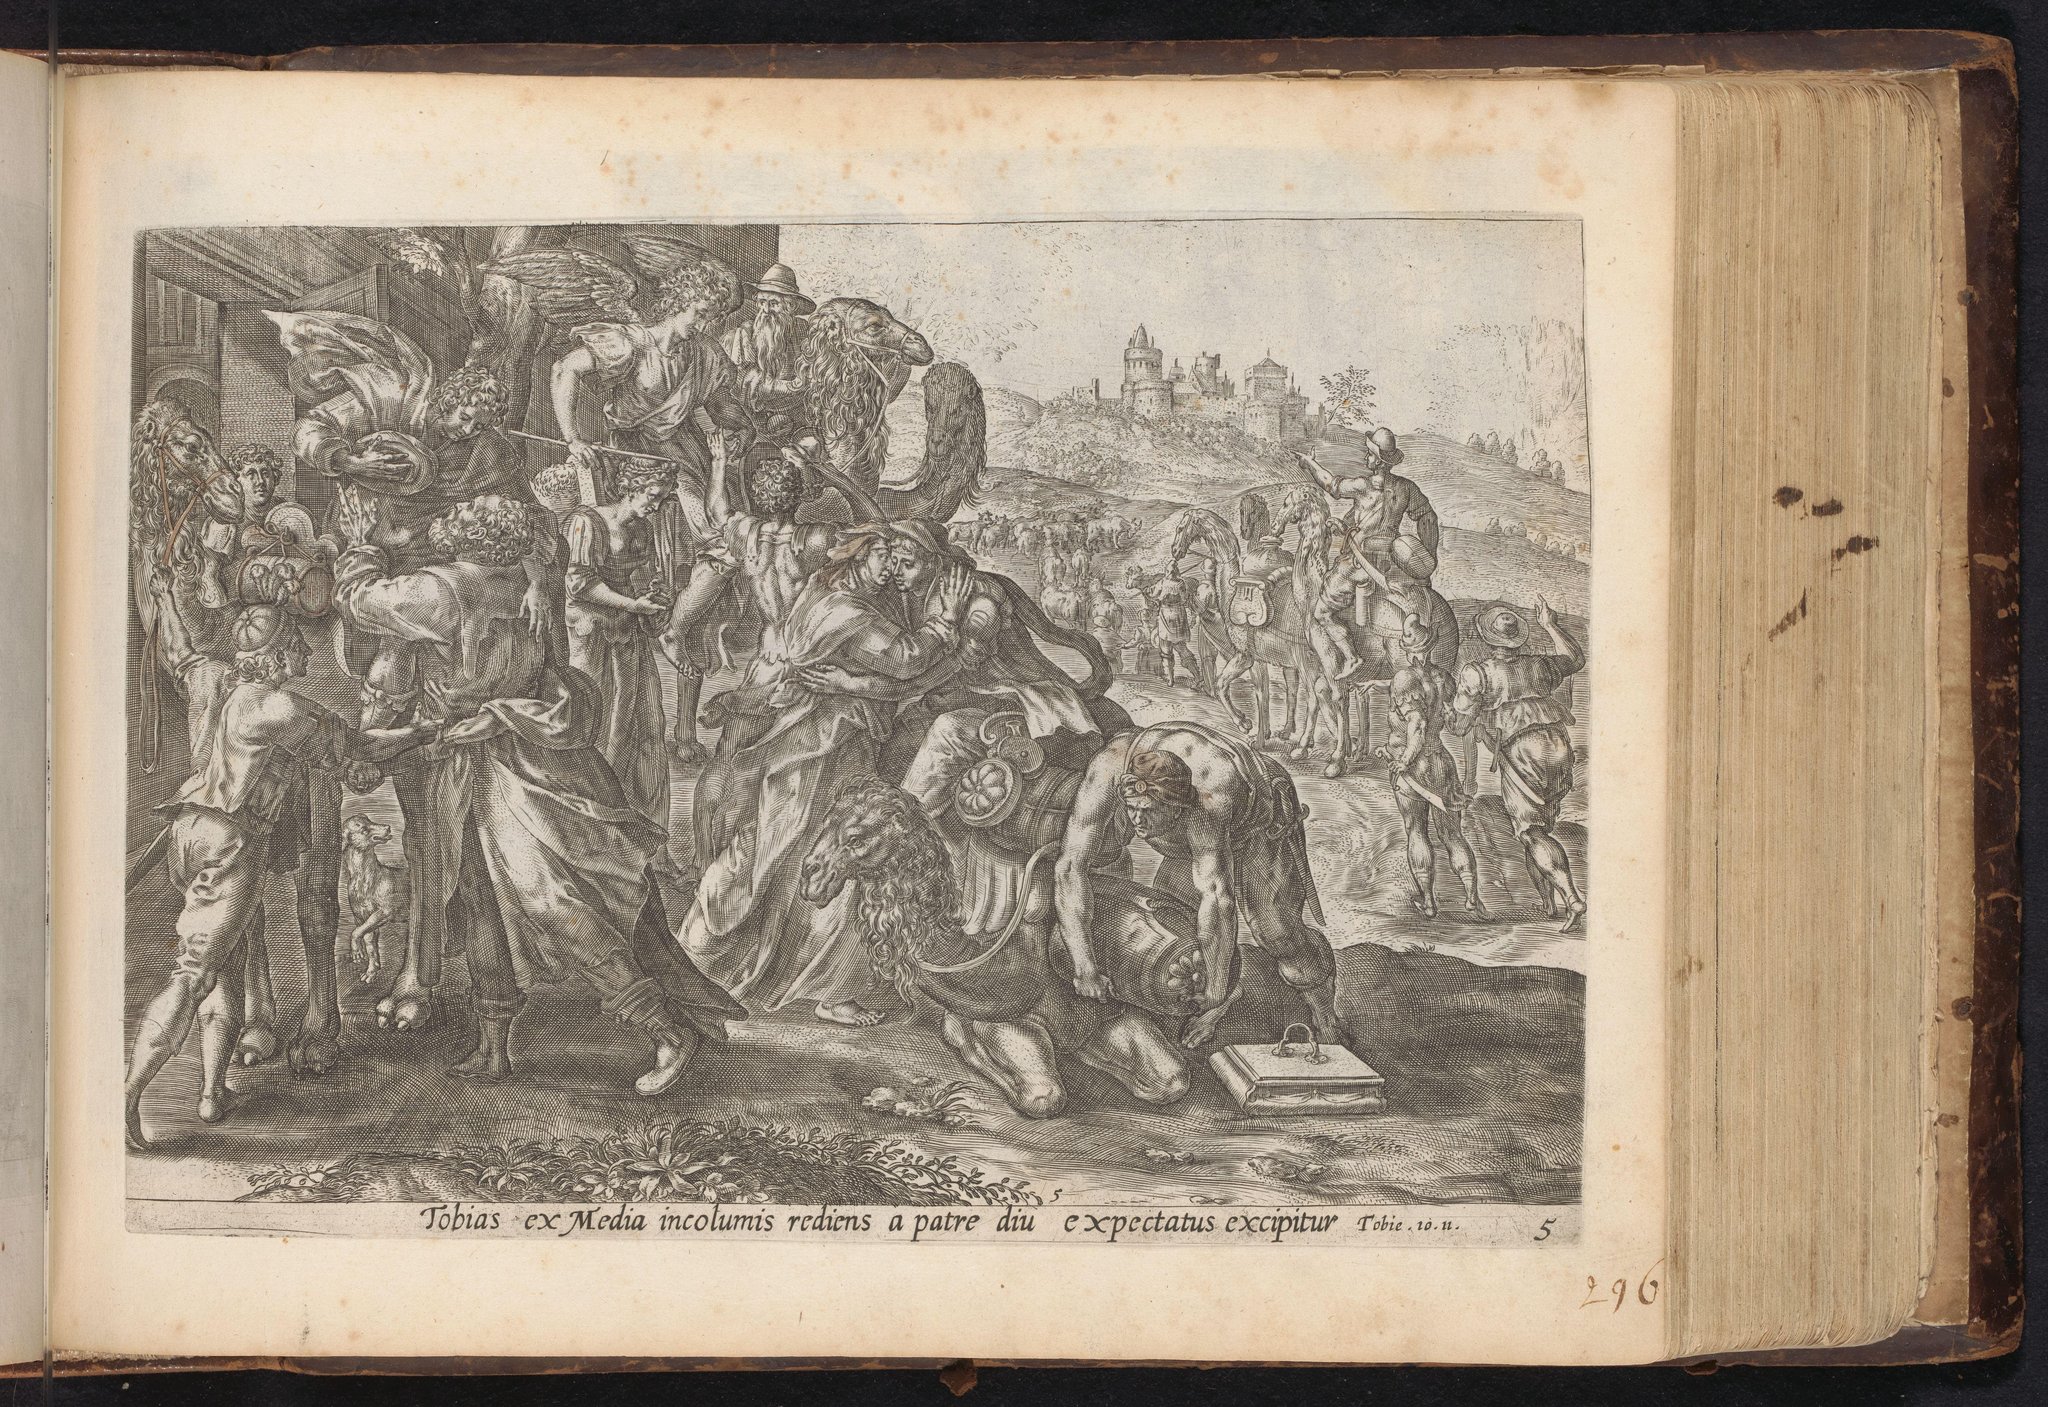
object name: album leaf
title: Geschiedenis van Tobias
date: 1585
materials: paper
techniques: engraving, hand coloring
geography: alkmaar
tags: the leave-taking ~ tobias' return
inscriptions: number: ‘296’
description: Raquel omhelst Tobias, die al op een kameel zit. Edna omhelst haar dochter Sara. Op de achtergrond zit de engel op een kameel. Rechts vertrekt de stoet. Onder de voorstelling een verwijzing in het Latijn naar de Bijbeltekst in Tobit. 10:11. Deze prent maakt deel uit van een album.